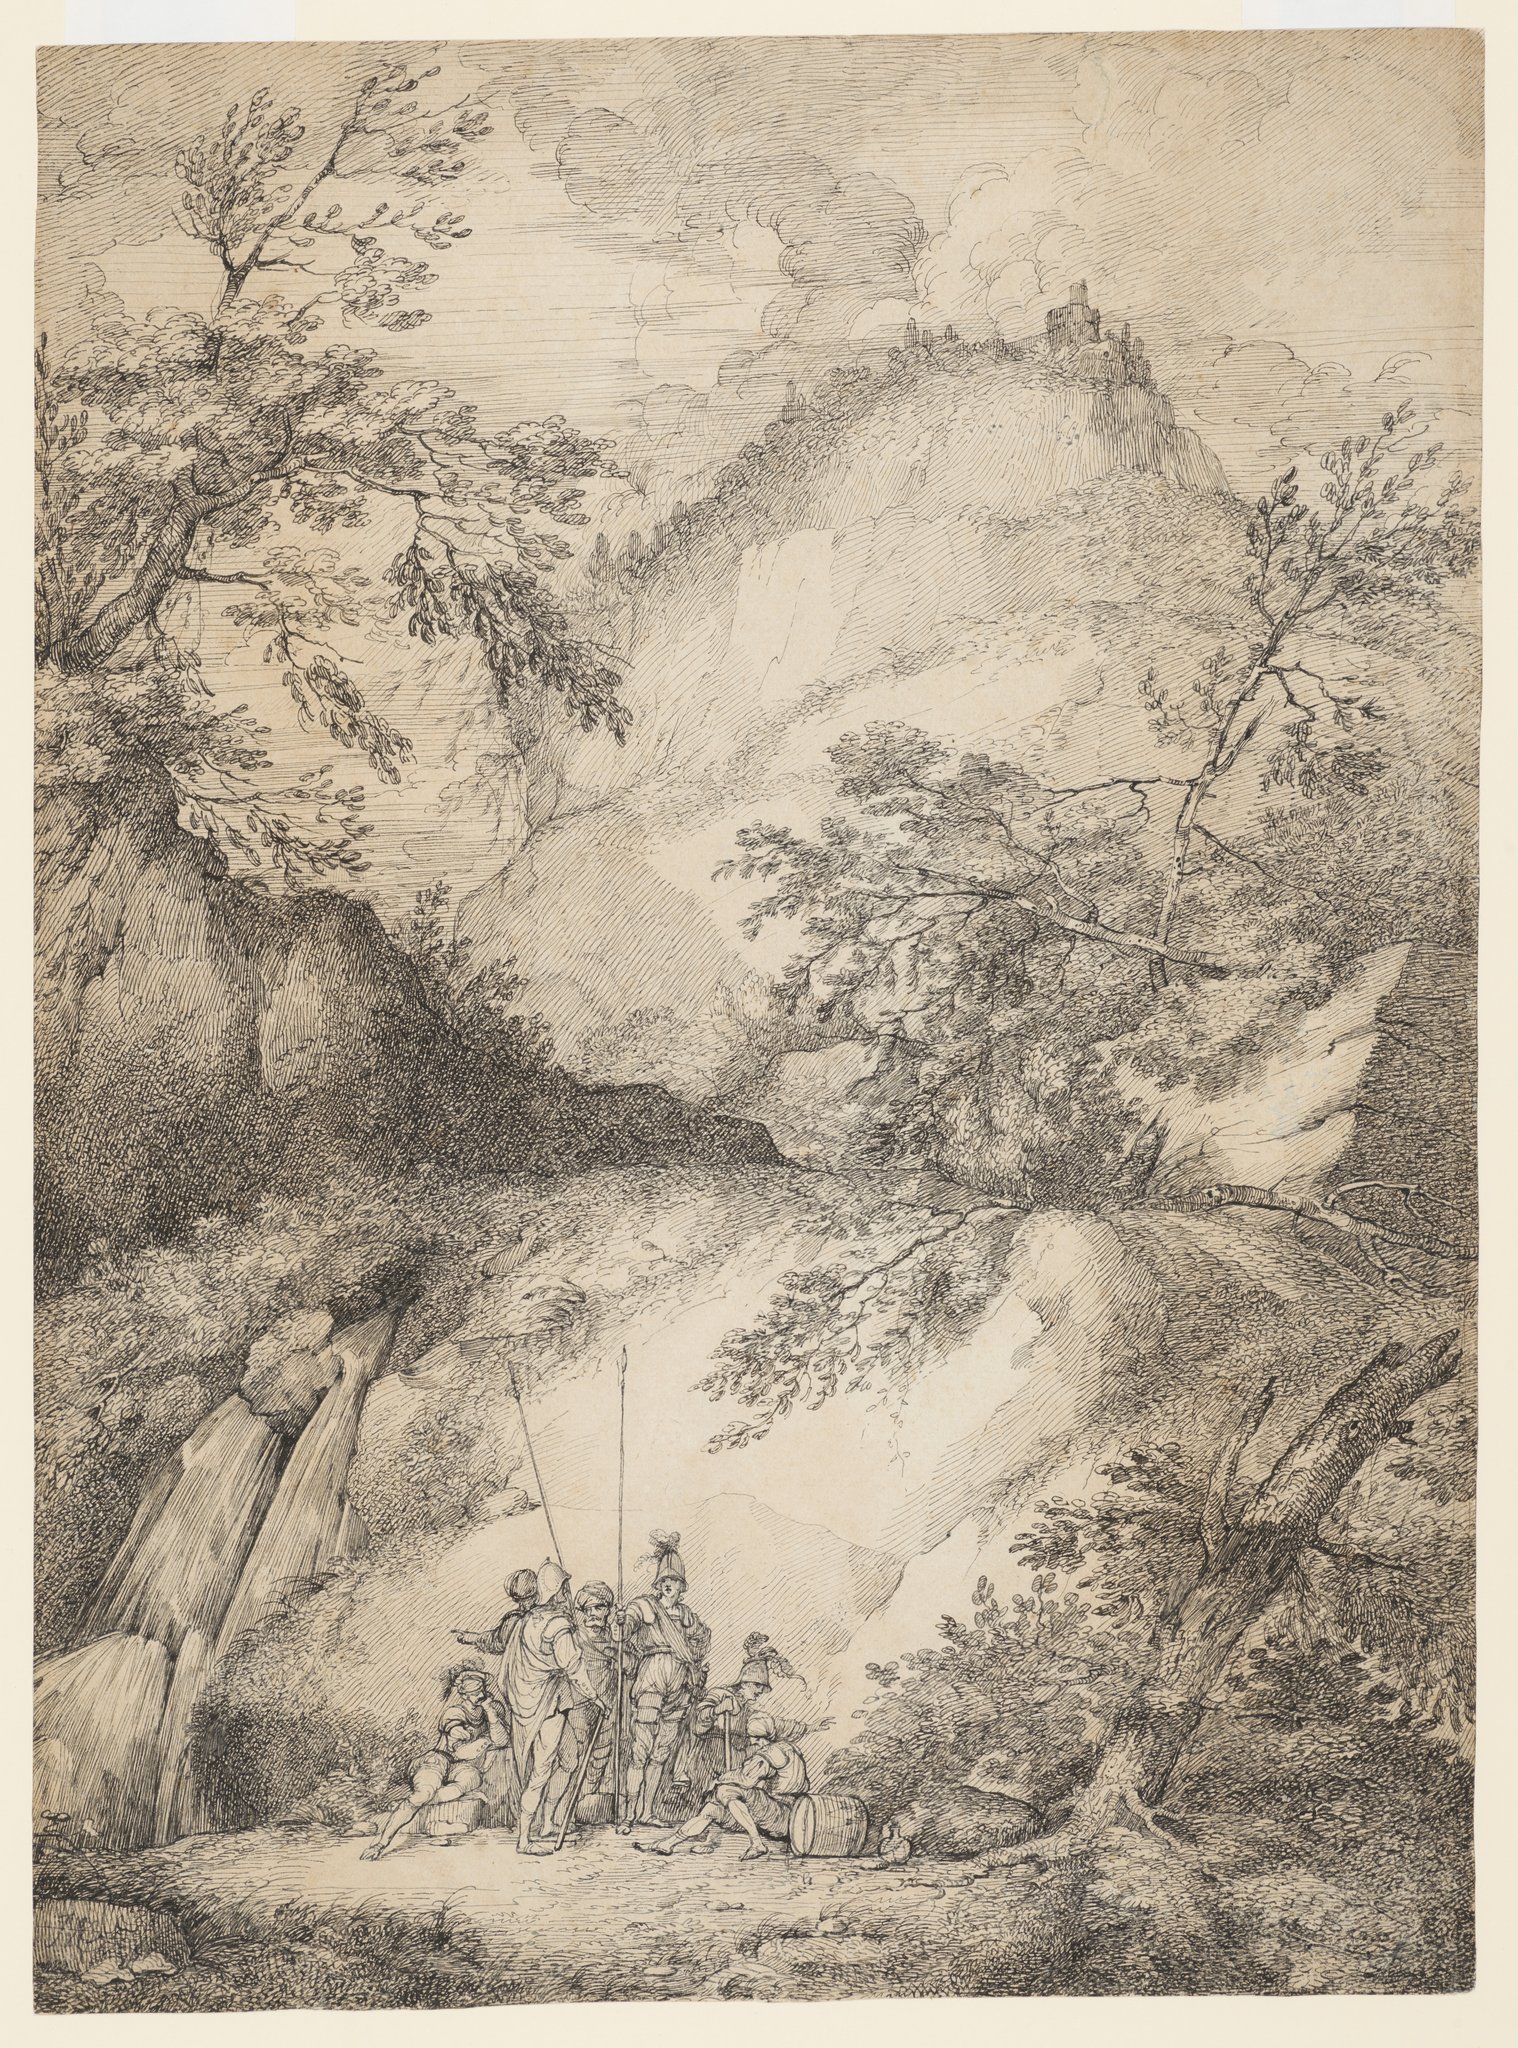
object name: drawing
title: Banditti in a mountainous landscape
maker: john hamilton mortimer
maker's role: artist and publisher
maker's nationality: british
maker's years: 1740-1779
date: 1770-1779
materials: ink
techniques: pen